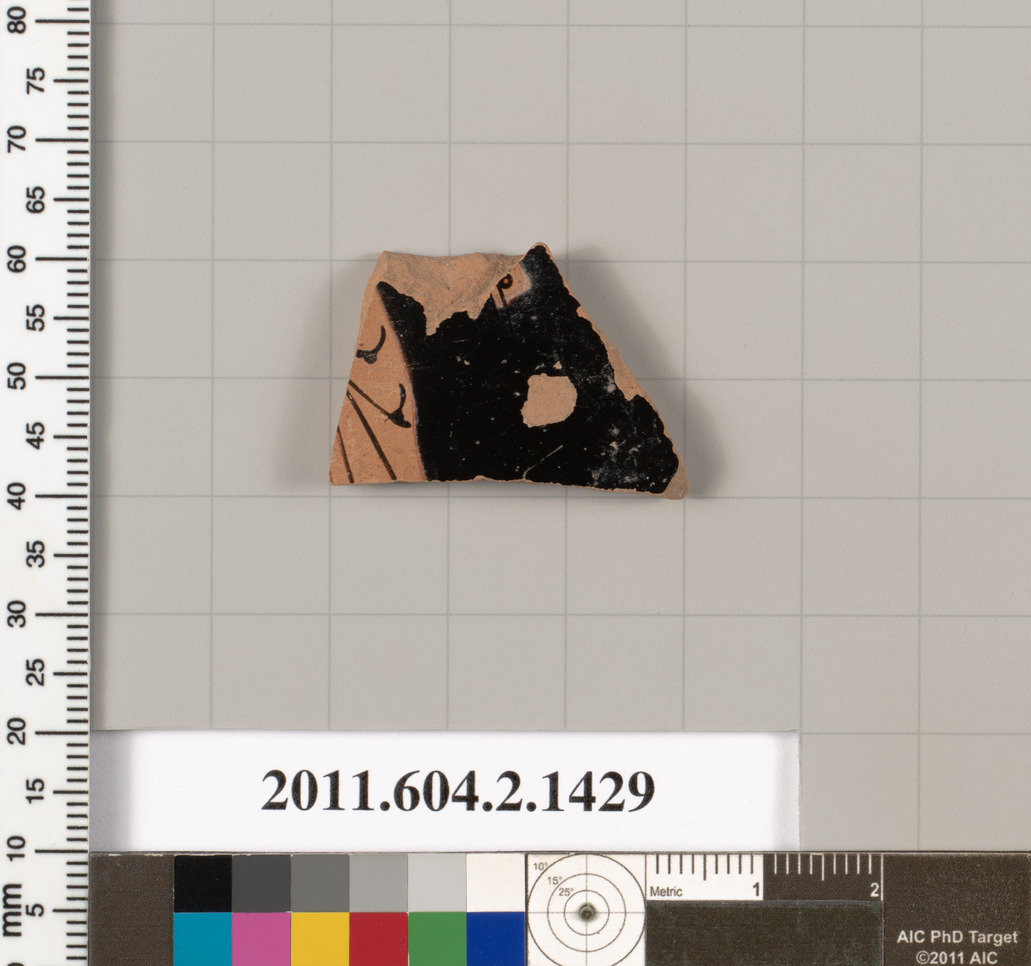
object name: skyphos fragment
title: Terracotta fragment of a skyphos (deep drinking cup)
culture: greek, attic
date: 475-451 BCE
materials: terracotta